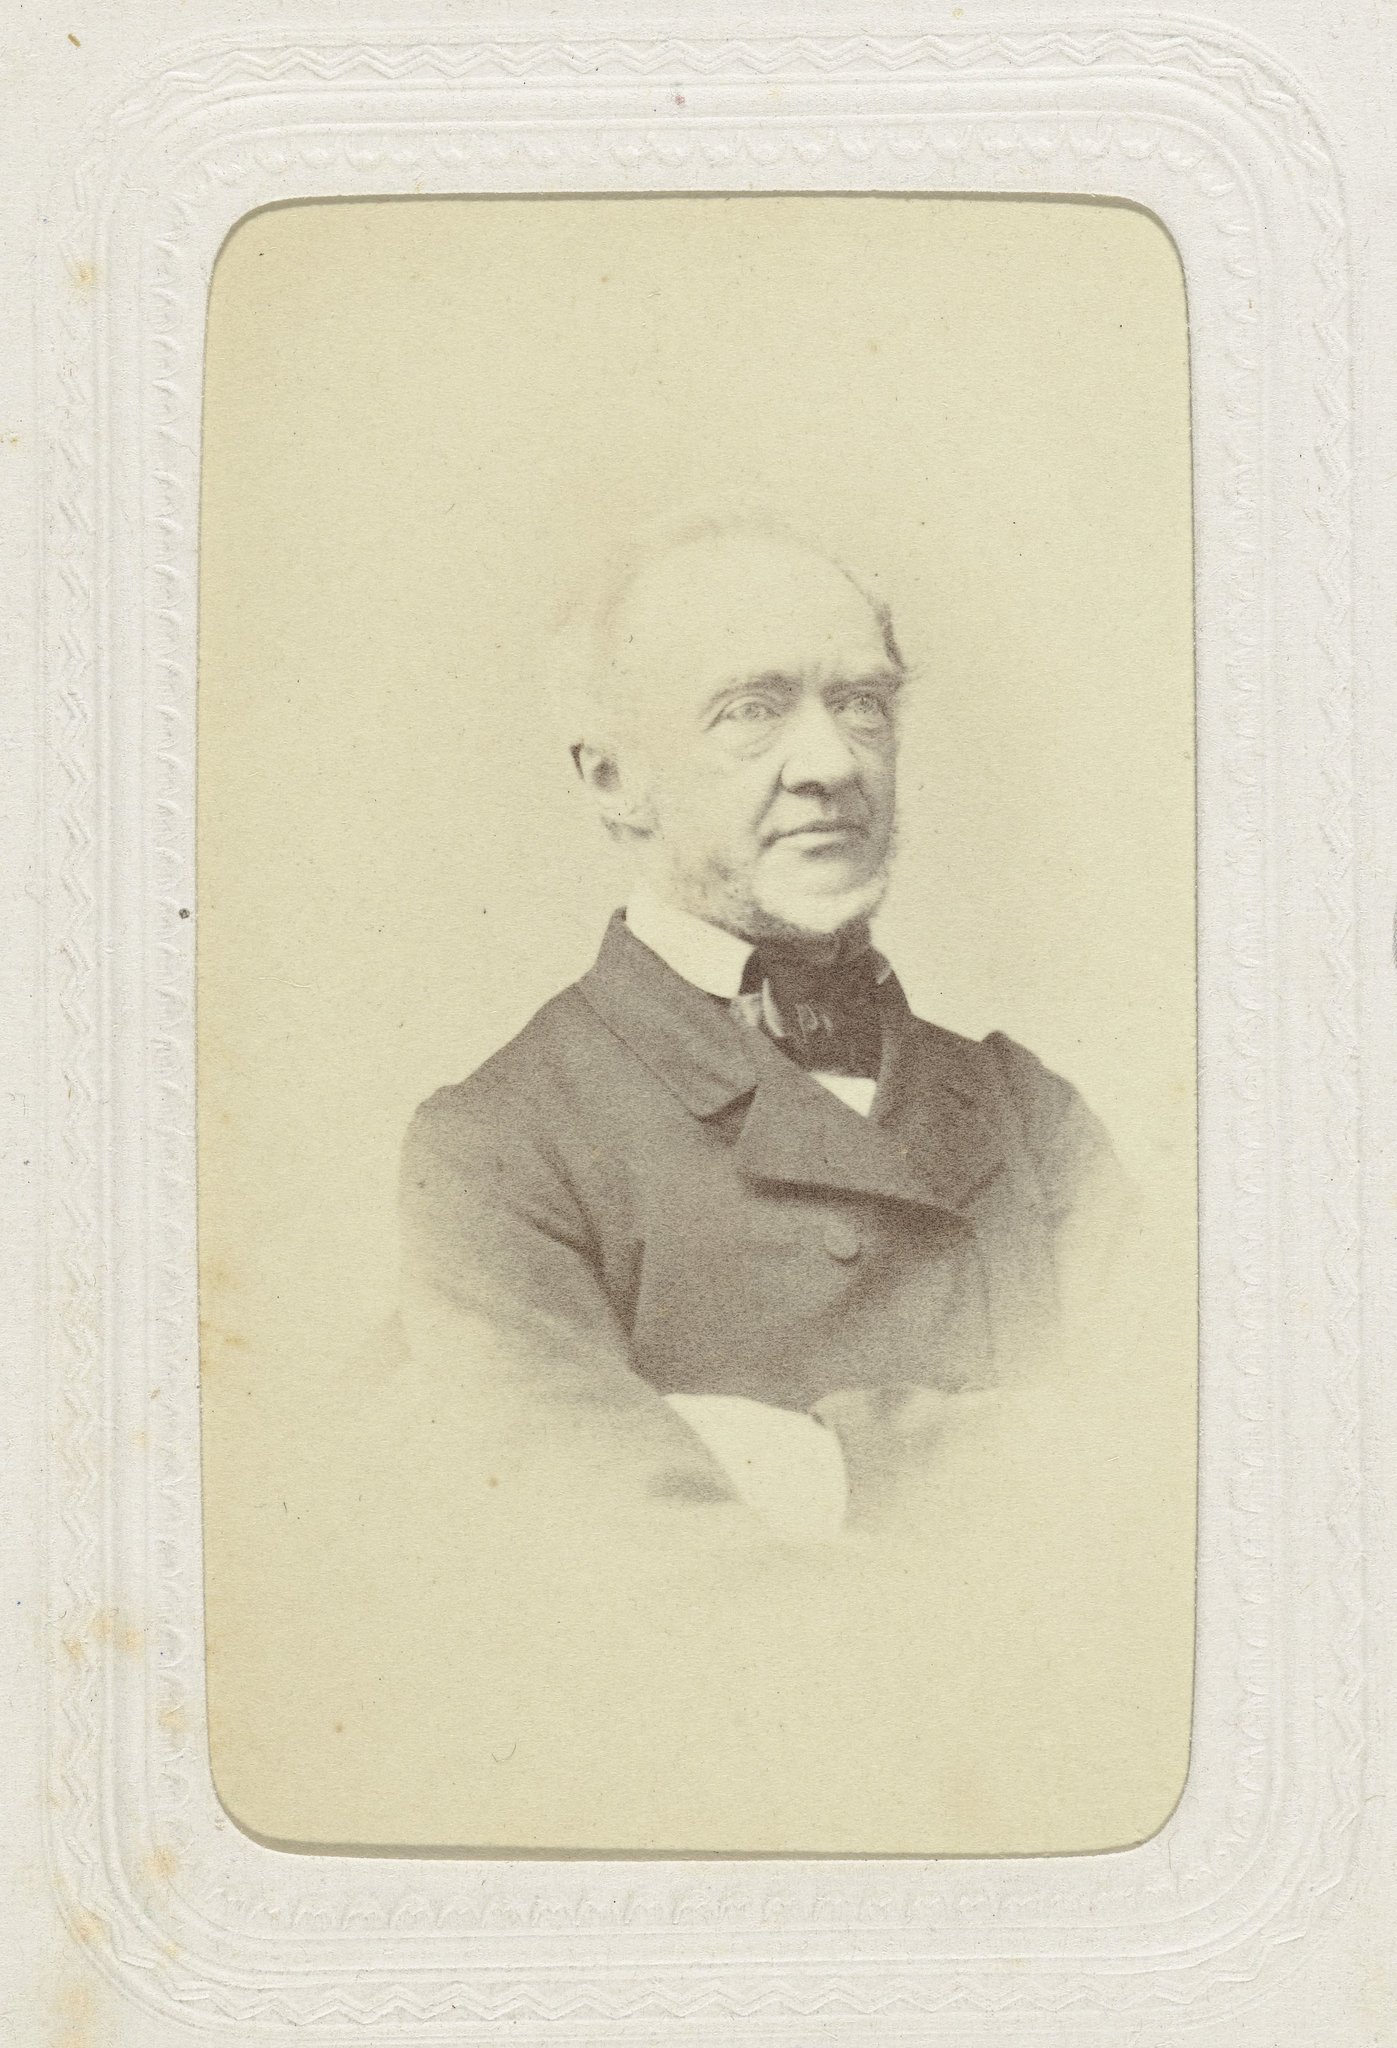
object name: carte de visite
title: Studioportret van een oudere man in kostuum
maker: august kampf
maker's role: fotograaf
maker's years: 1836-1914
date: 1863-1866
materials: cardboard, paper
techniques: albumen print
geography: aachen